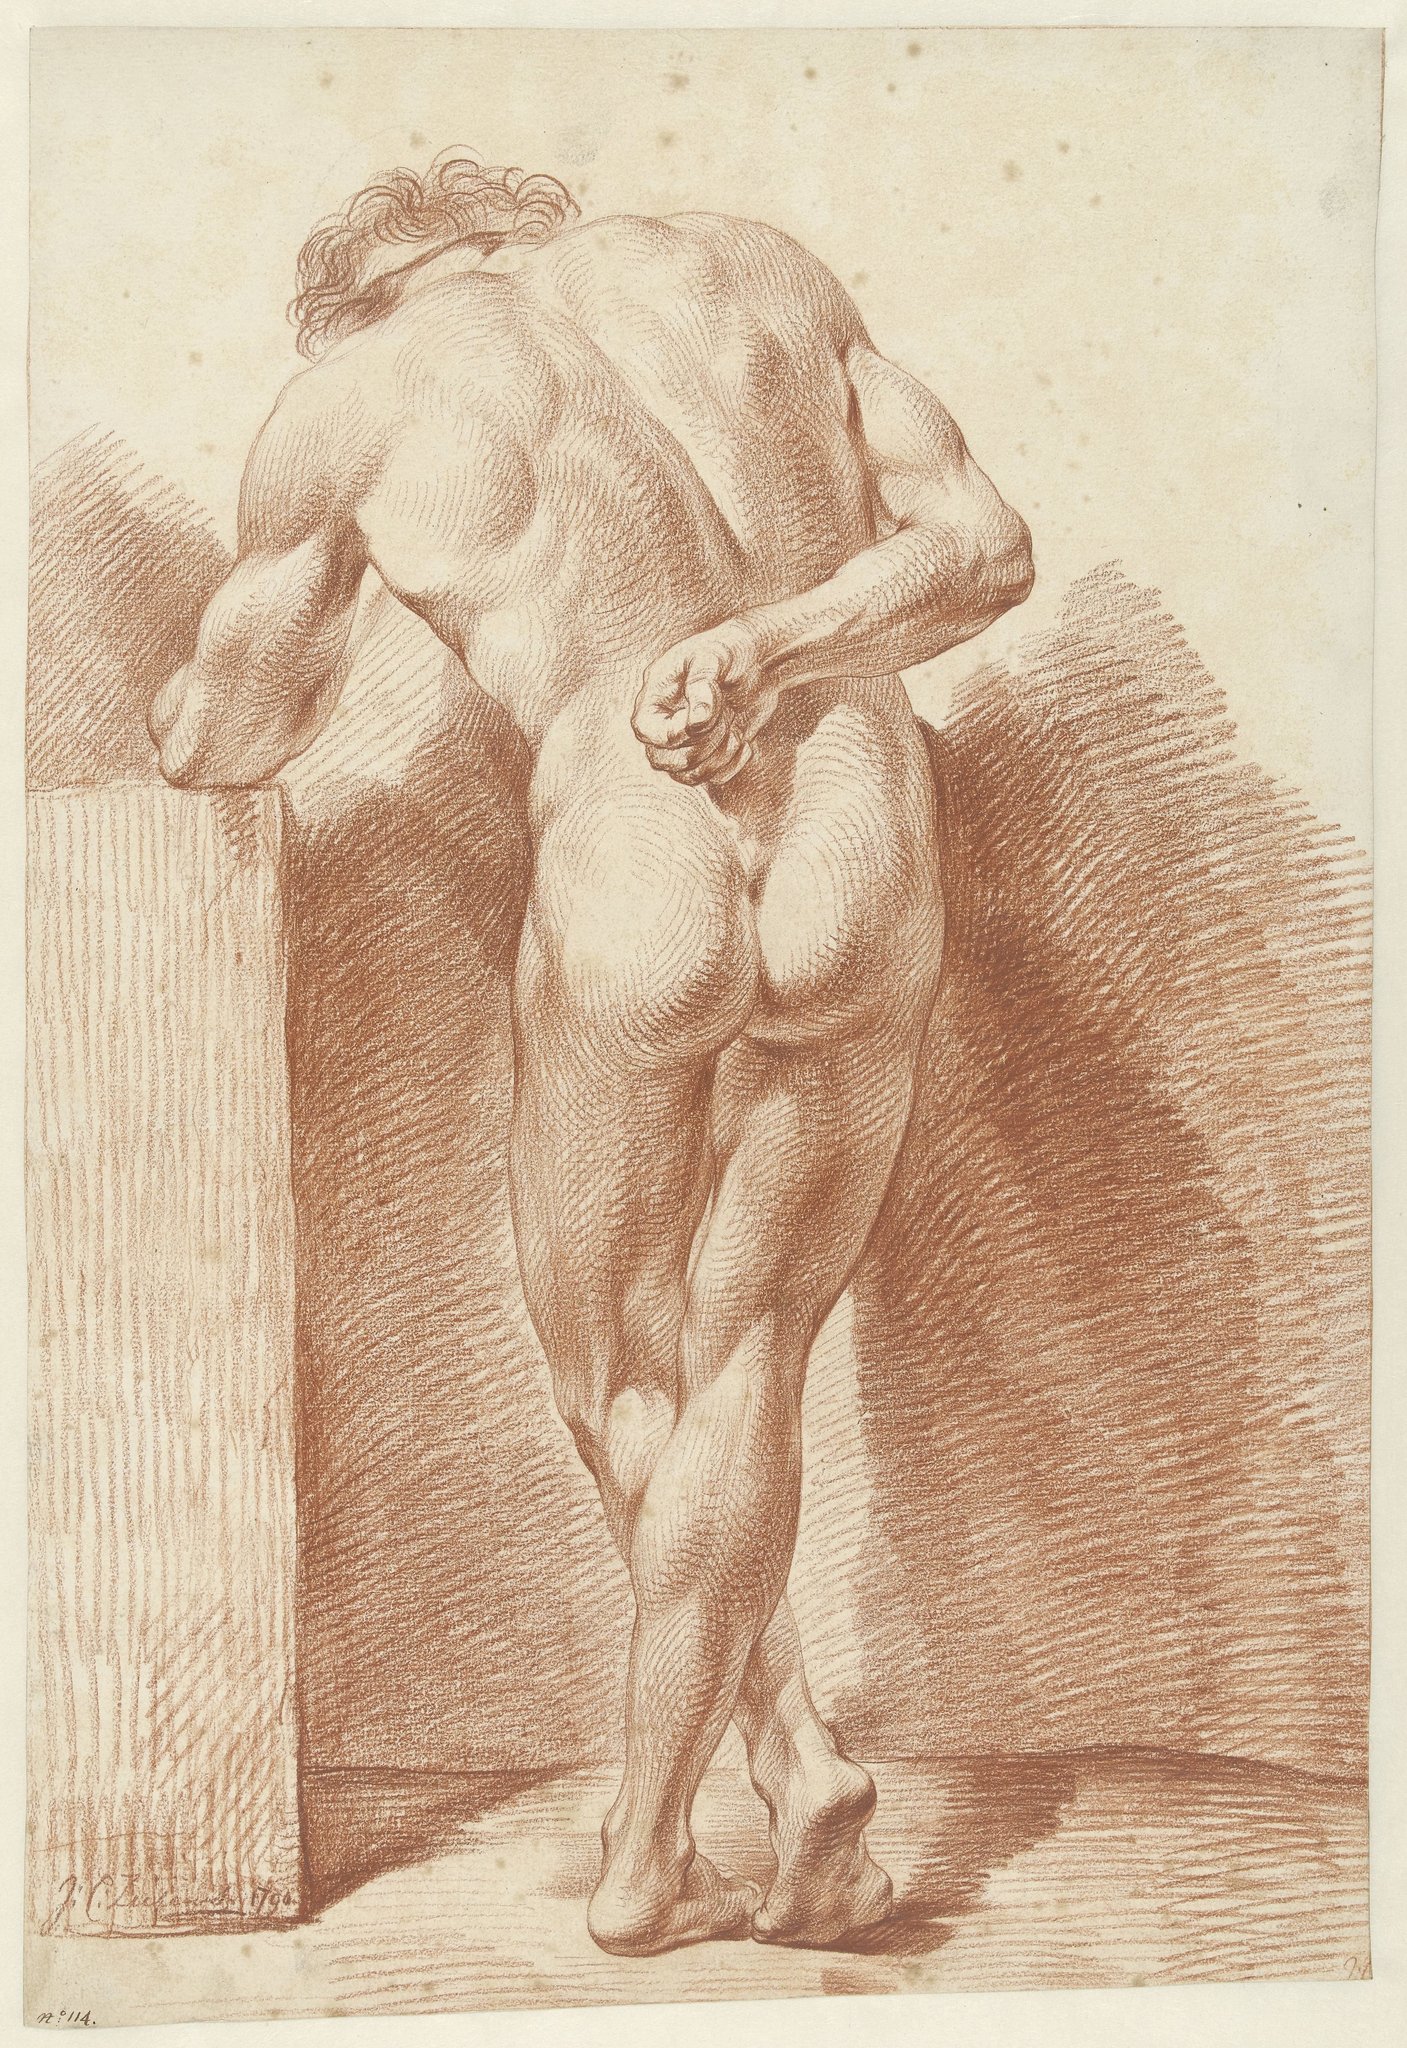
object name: drawing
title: Staand mannelijk naakt, op de rug gezien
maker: johannes ziesenis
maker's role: draughtsman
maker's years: 1770-1799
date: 1790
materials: chalk, paper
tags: postures of the human figure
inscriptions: inscription: ‘Voor de stelbeurt van D. Vrydag / den : November 1799’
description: Staand mannelijk naakt, op de rug gezien, de rechterarm op de rug, de benen gekruist. Rechtsonder: no. 114.